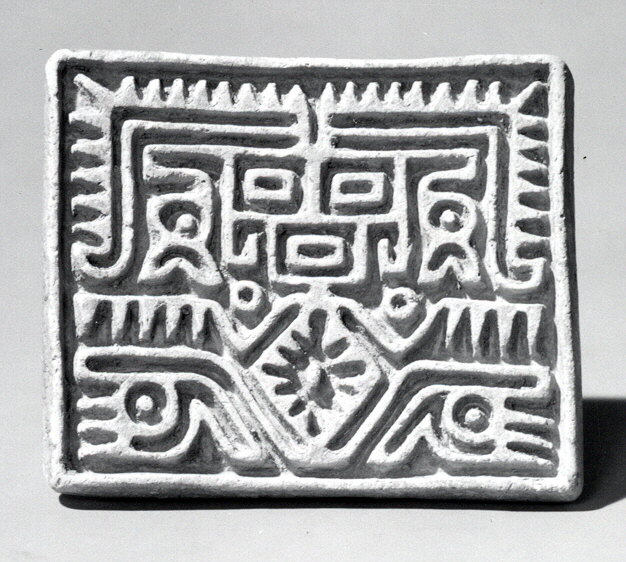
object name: stamp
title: Flat Stamp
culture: central highlands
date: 1101-1500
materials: ceramic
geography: mexico